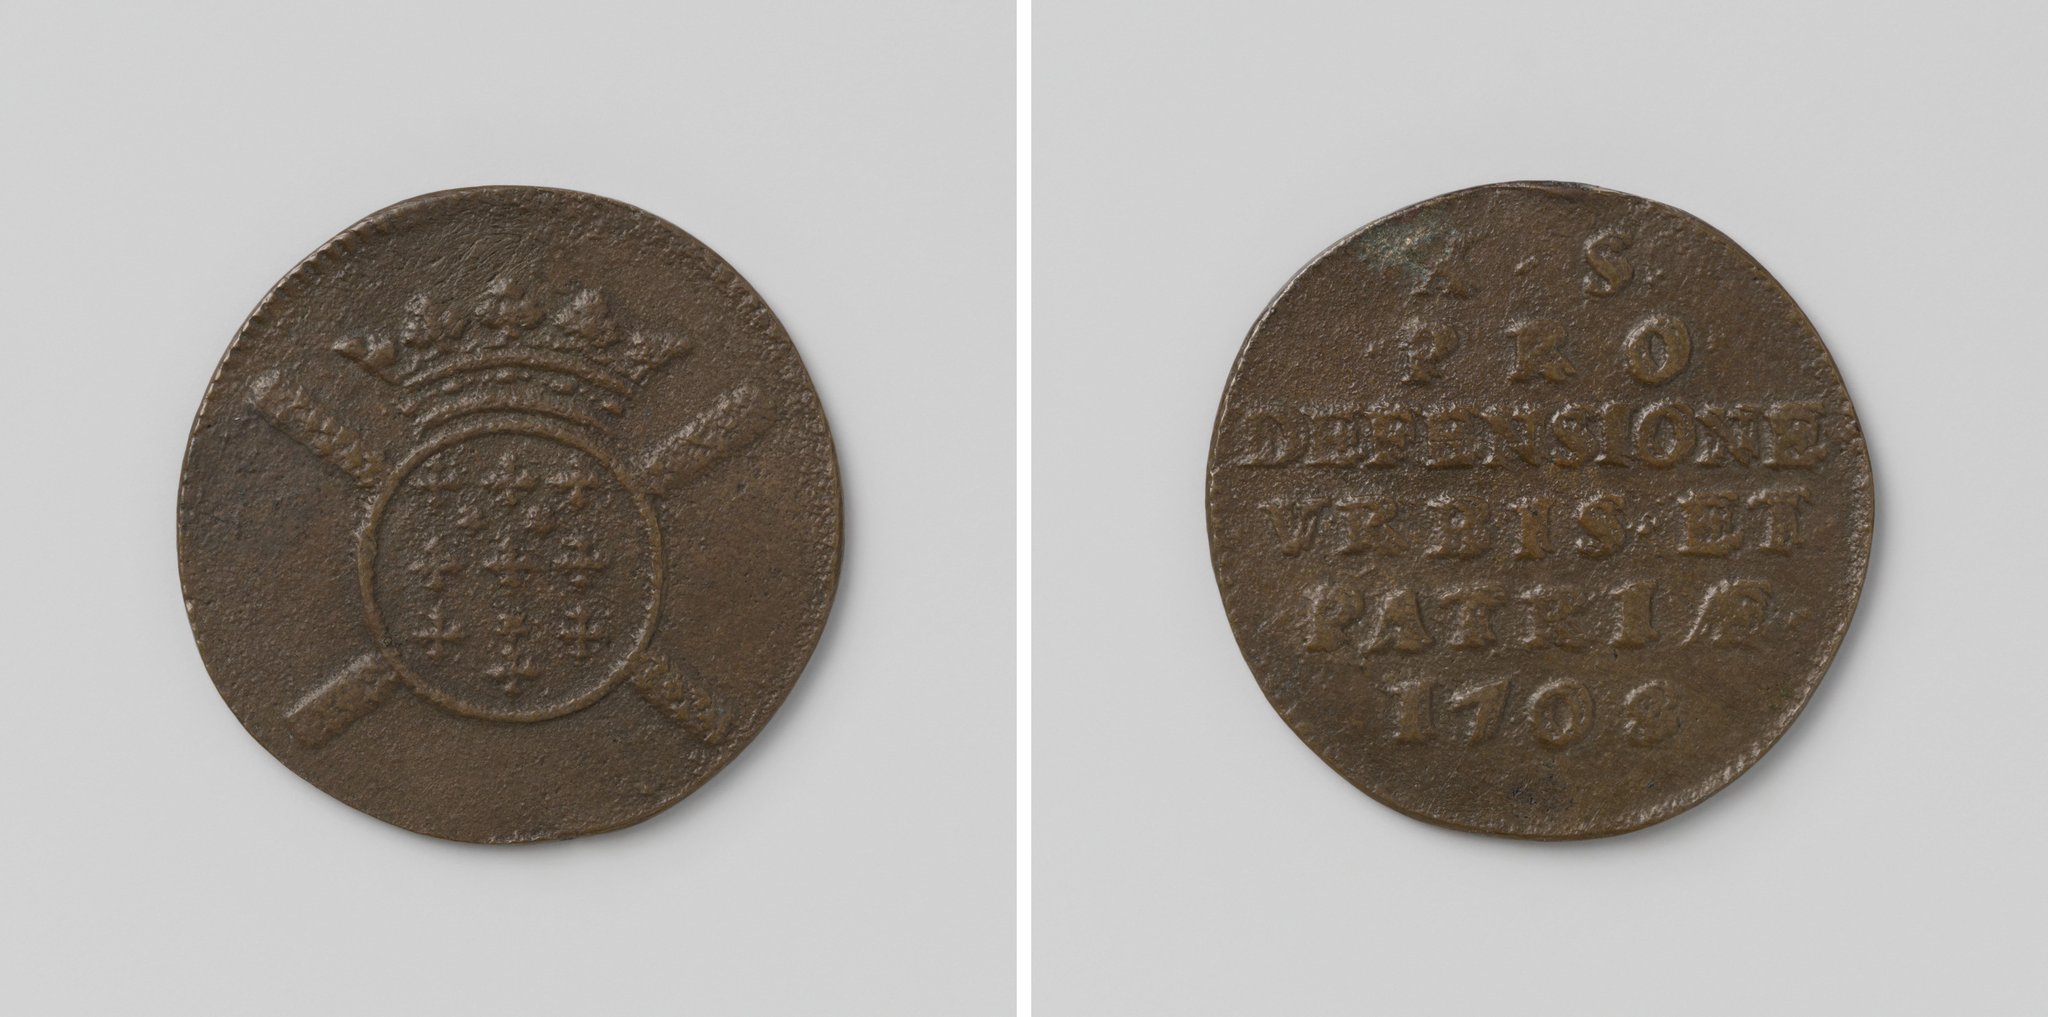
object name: siege coin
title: tien stuiver, noodmunt van Rijssel, door de bondgenoten ingenomen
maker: Anonymous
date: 1708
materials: copper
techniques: striking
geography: lille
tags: lille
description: Voorzijde: gekroond wapenschild op twee gekruiste maarschalkstaven. Keerzijde: opschrift